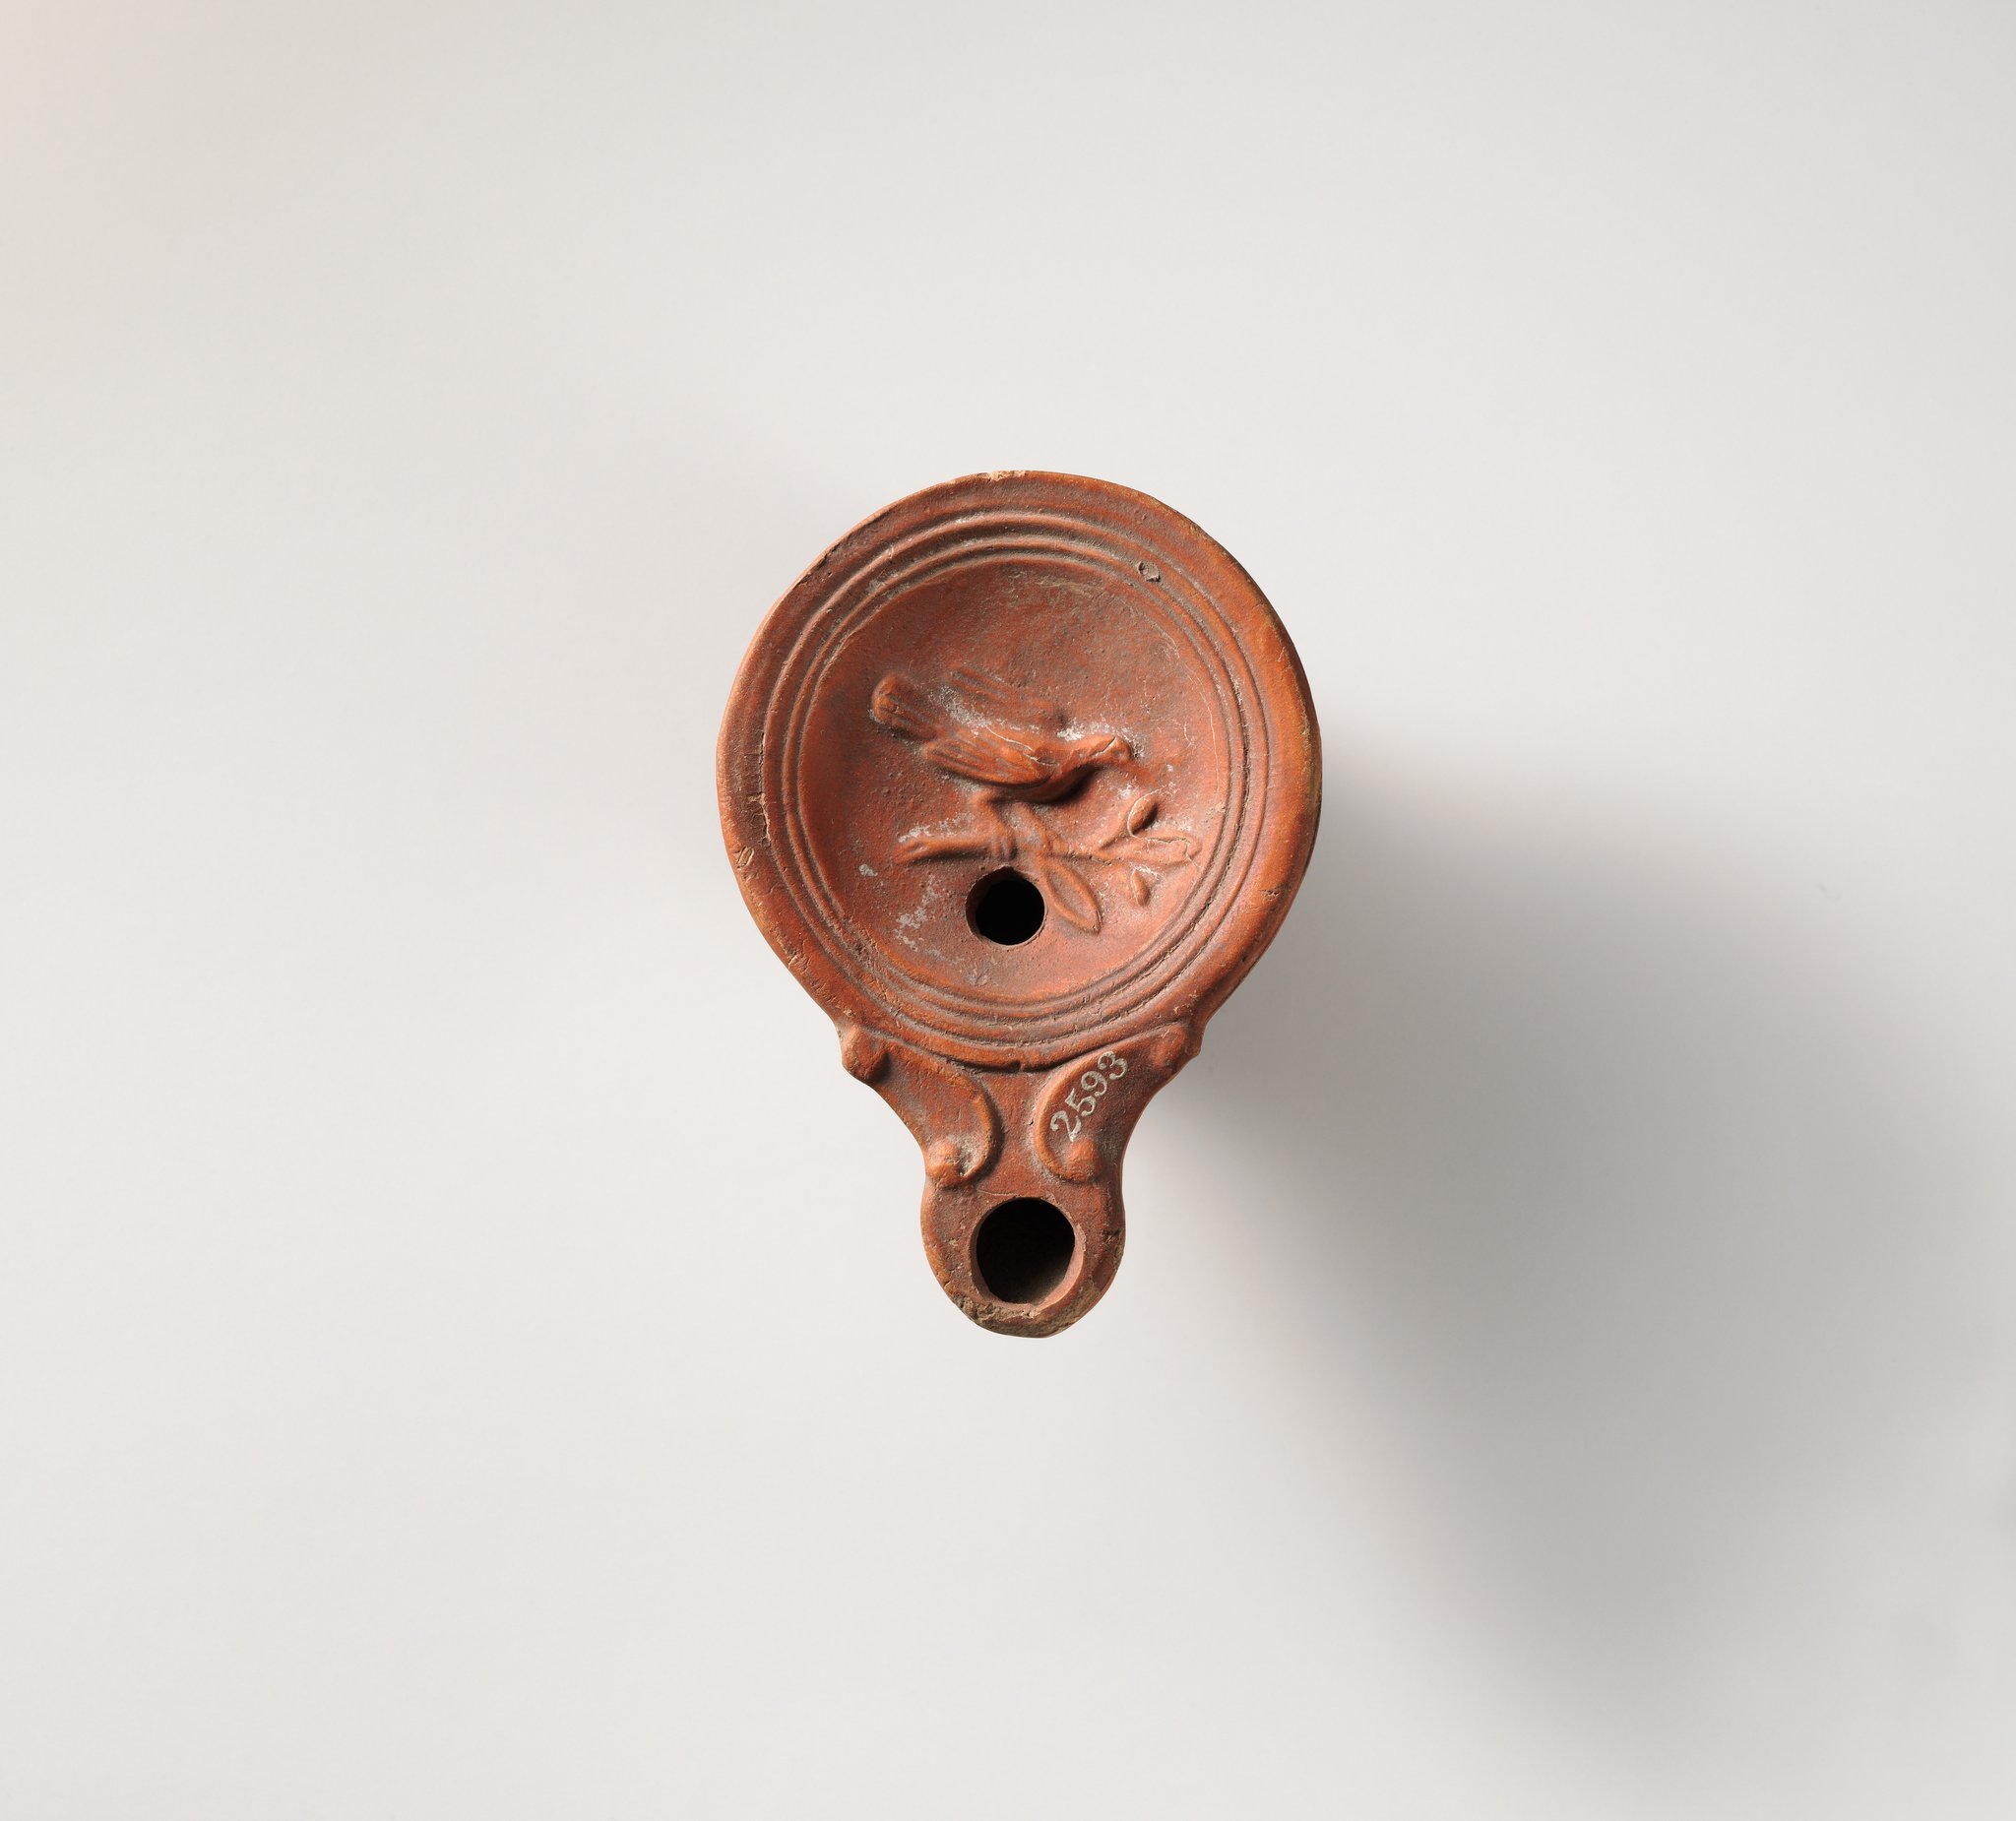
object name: lamp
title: Terracotta oil lamp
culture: roman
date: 40-100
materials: terracotta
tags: birds